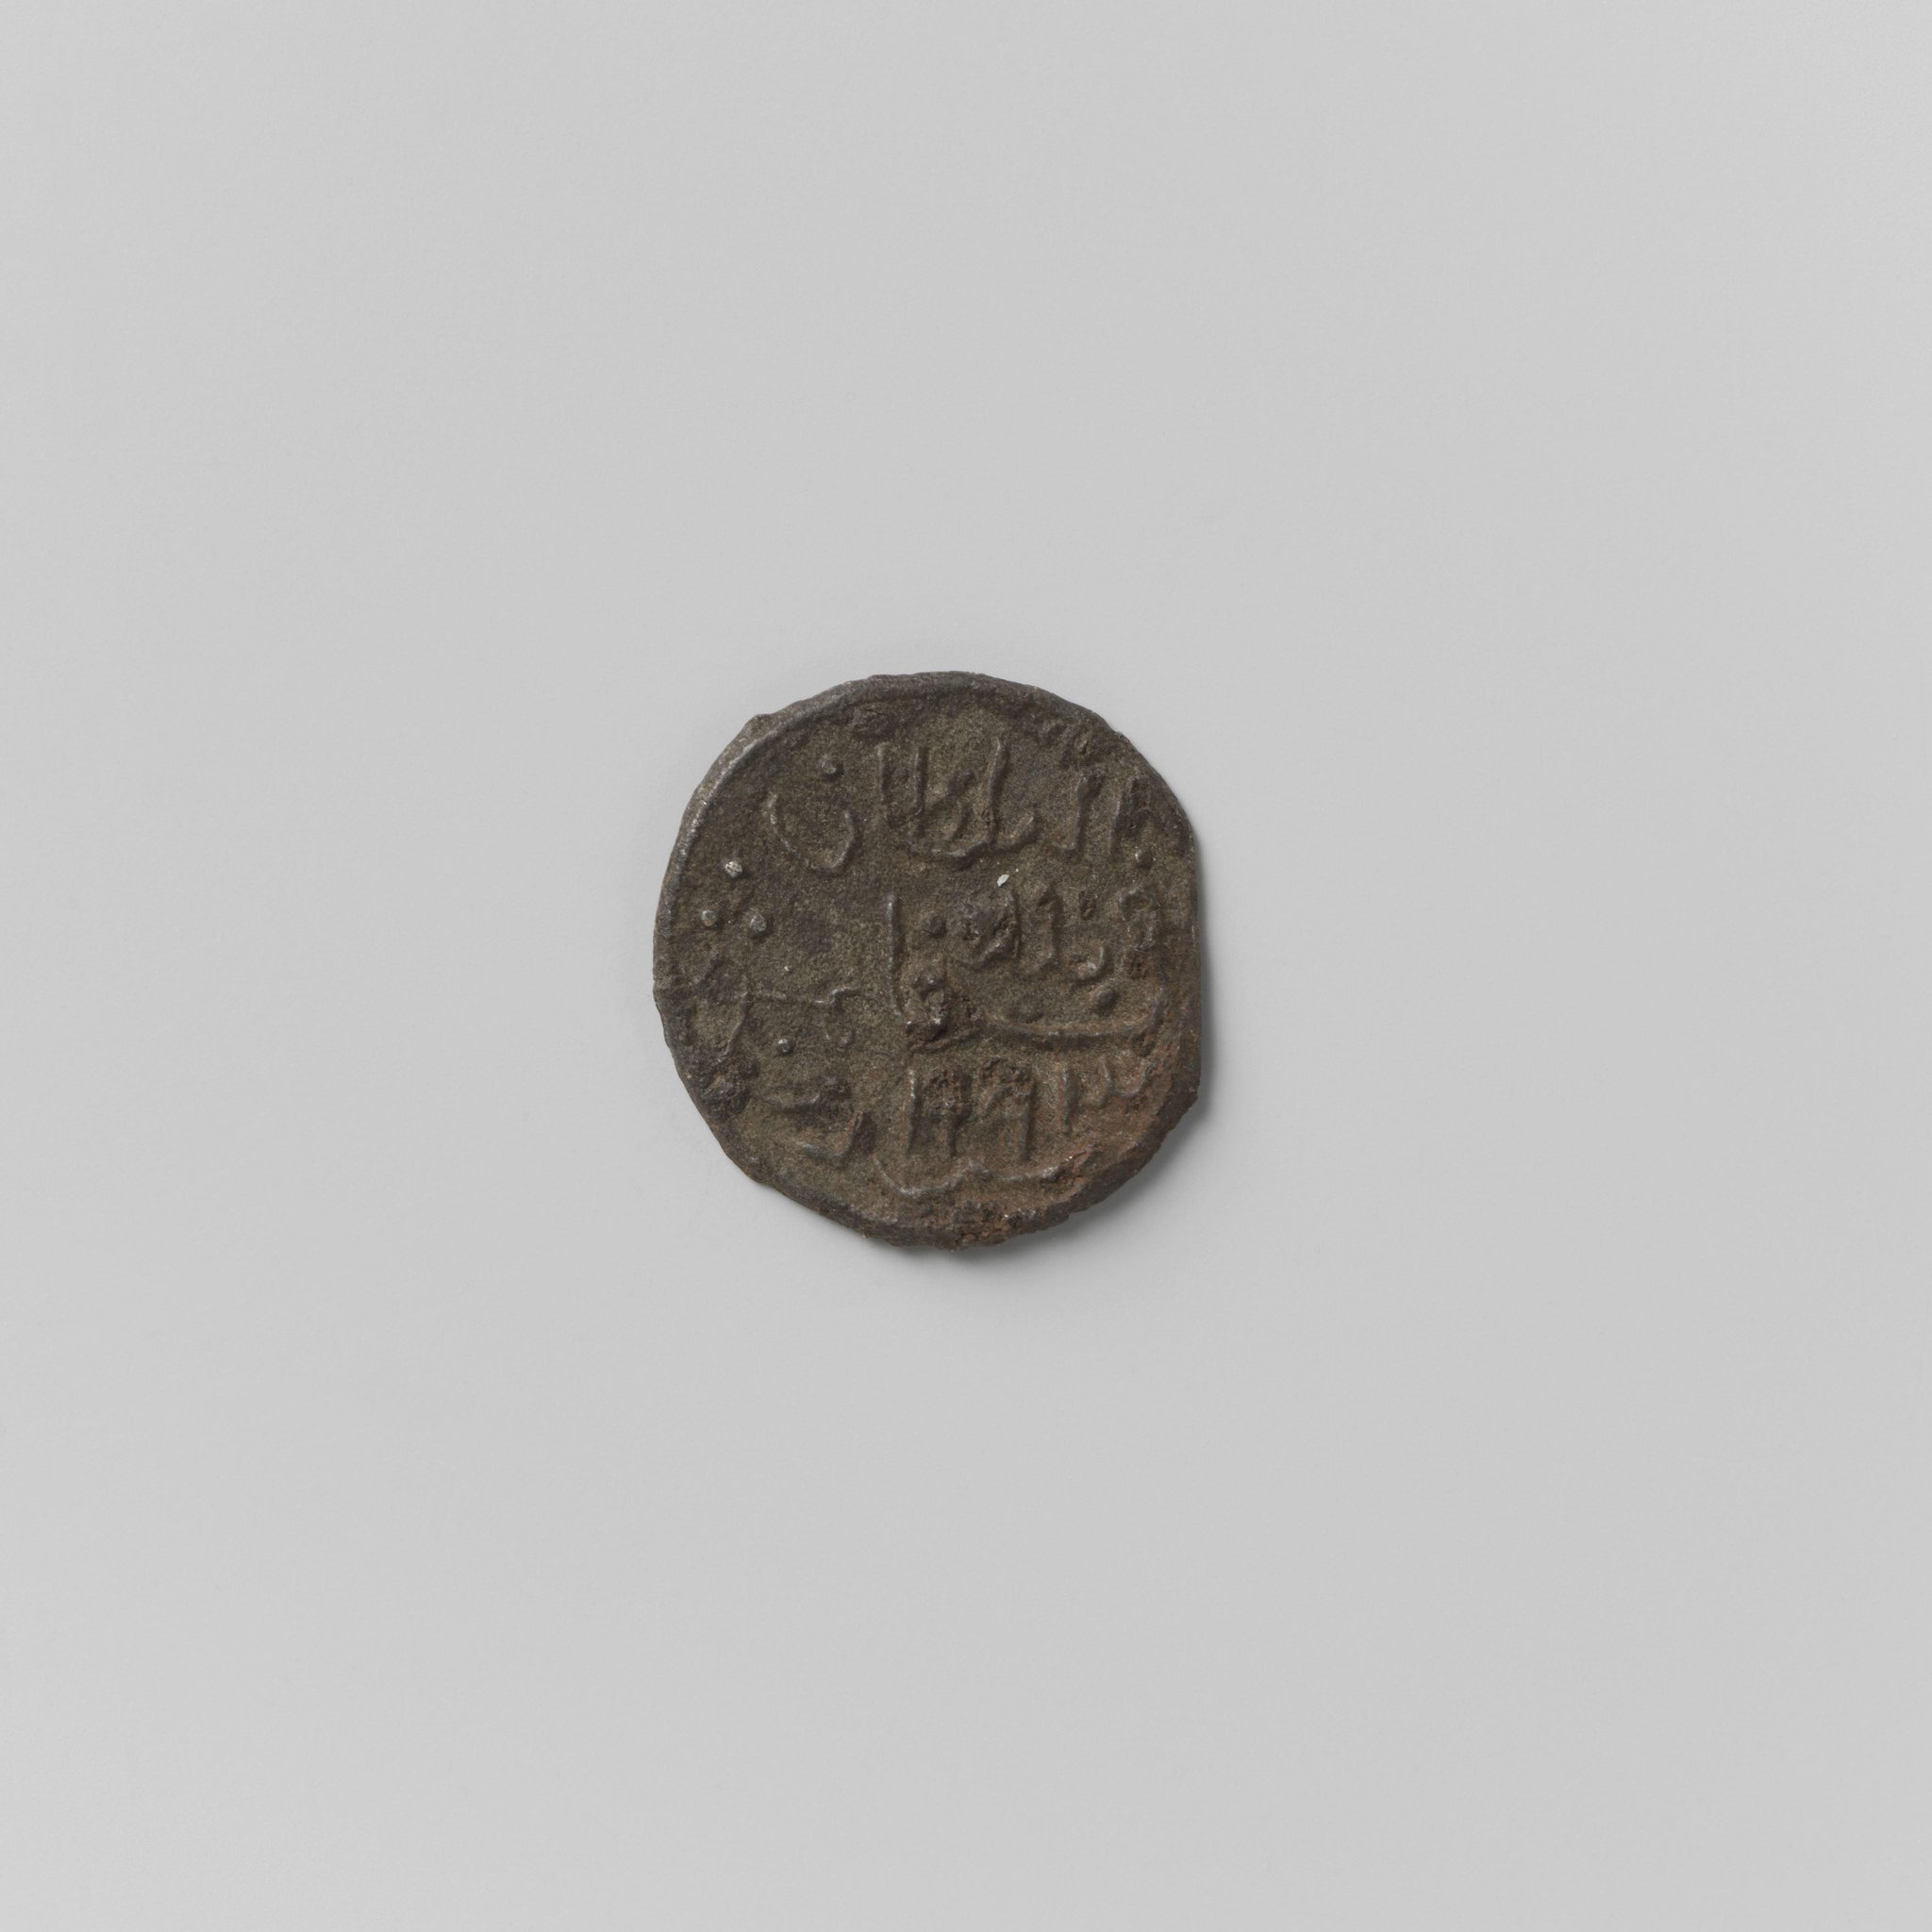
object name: coin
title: Palembang, Sumatra, sultan Mohammed Beha ed-din, pitji, A.H. 1193 (1779)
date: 1779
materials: tin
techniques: casting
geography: palembang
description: Tinnen munt. Voorzijde: drieregelig opschrift in Arabische lettertekens, waartussen jaartal in Islamitische jaartelling. Keerzijde, glad.